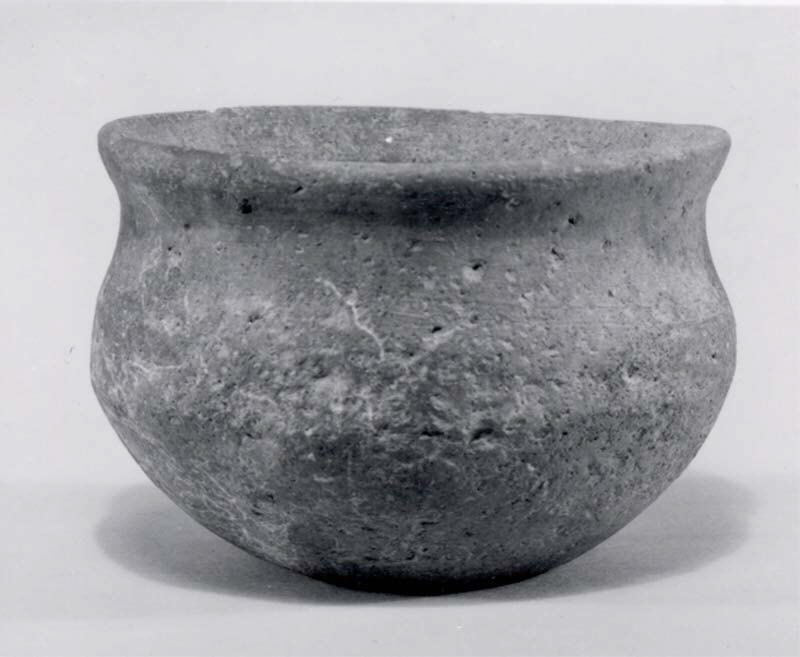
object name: bowl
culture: iranian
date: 900-801 BCE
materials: ceramic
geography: iran